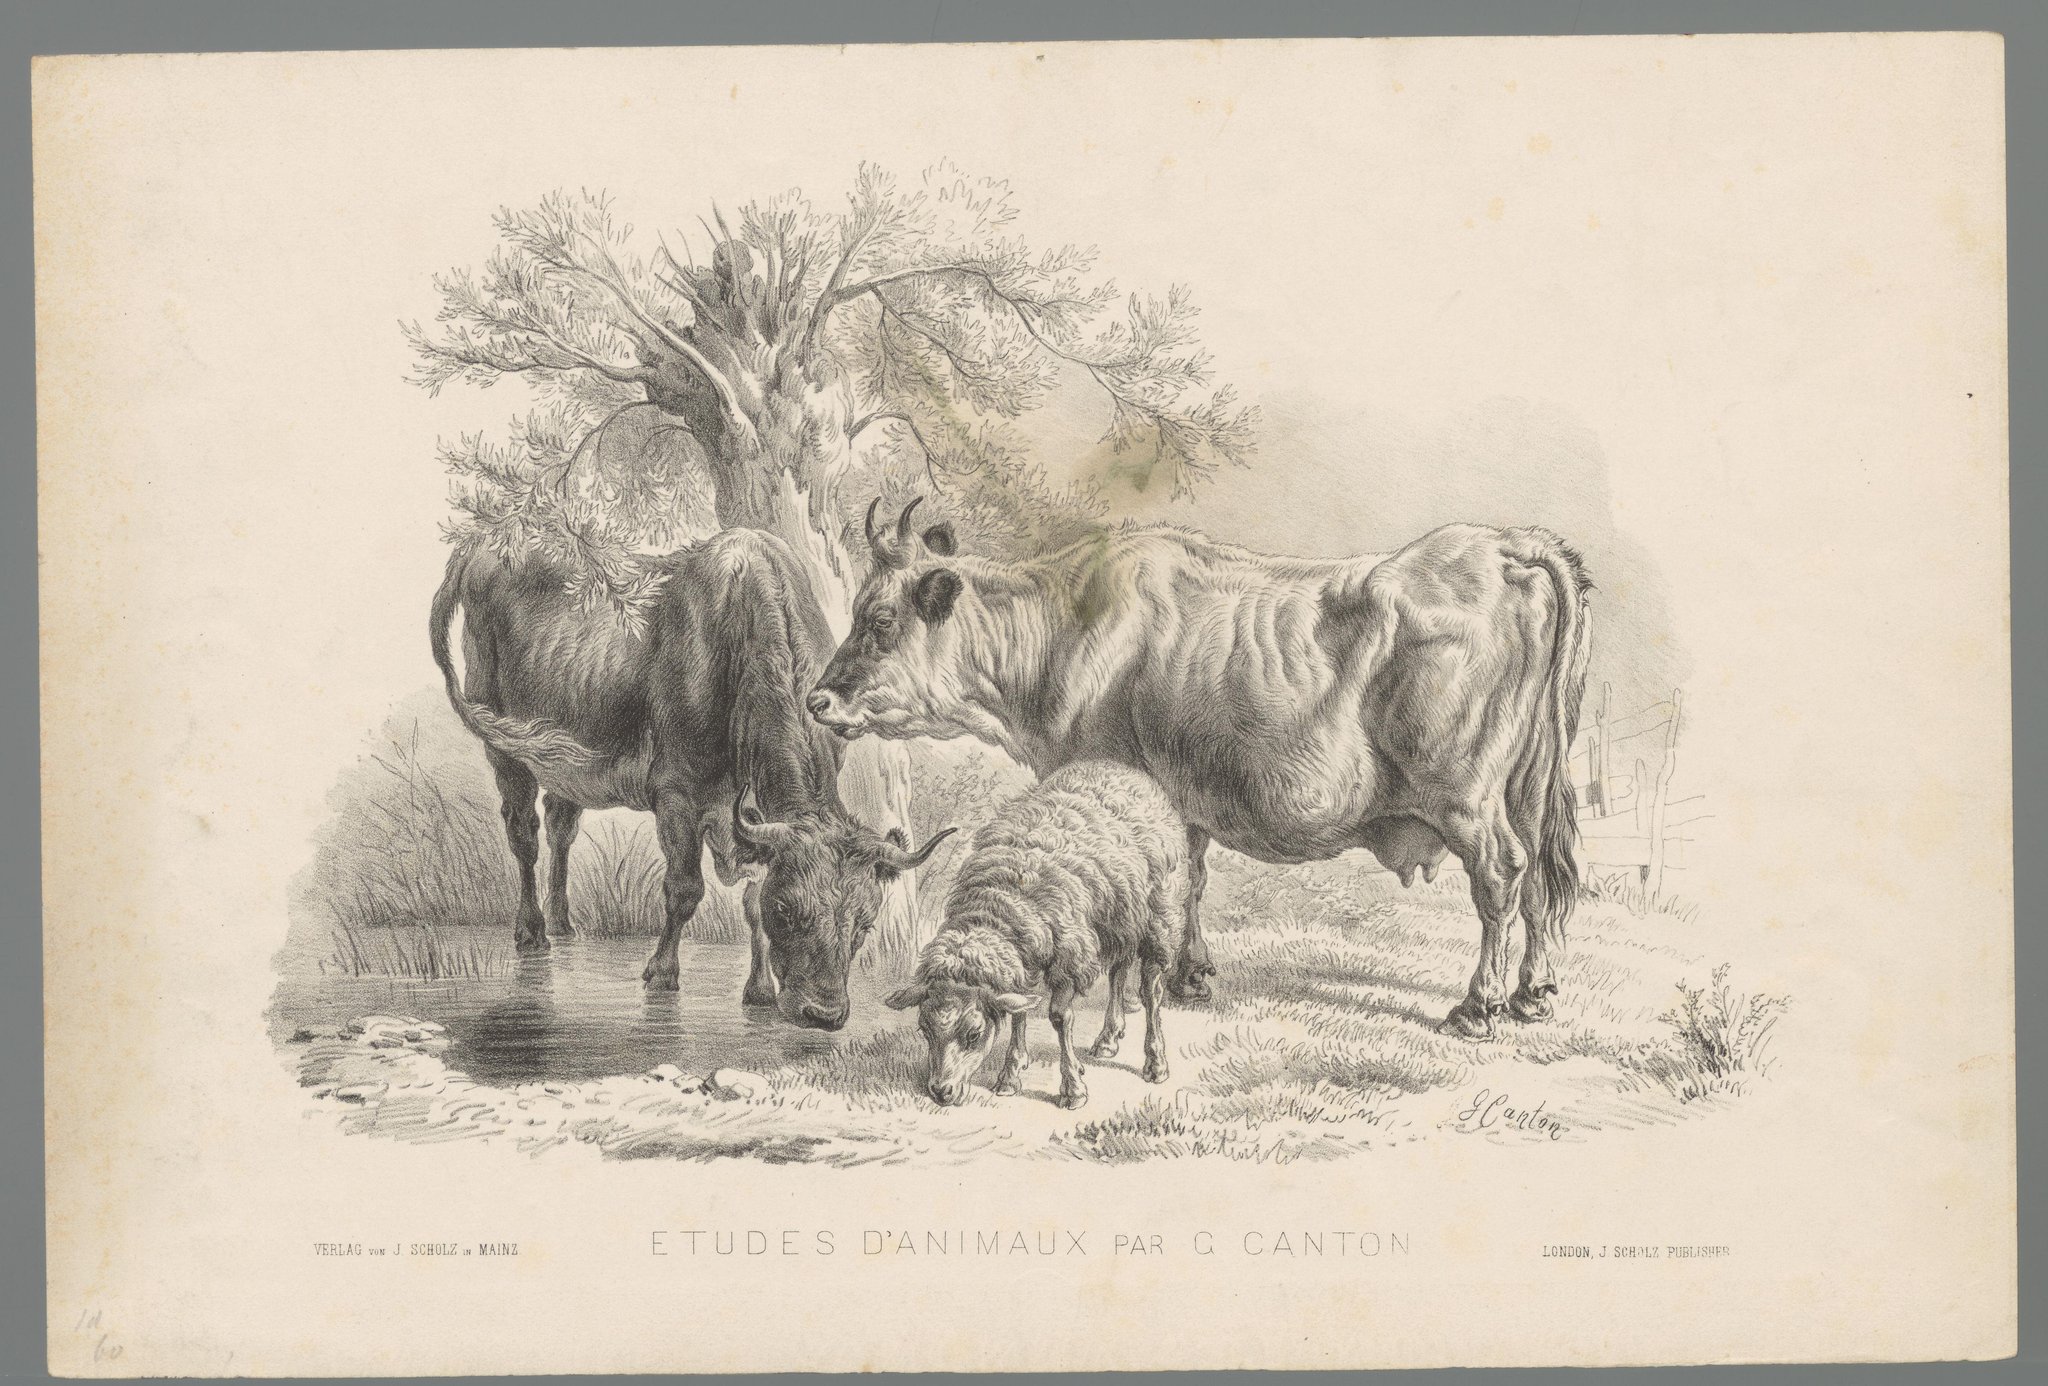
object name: print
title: Dierstudies door Gustav Canton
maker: gustav jakob canton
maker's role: print maker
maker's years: 1813-1885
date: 1823-1885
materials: paper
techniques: lithograph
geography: mainz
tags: landscapes with waters, waterscapes, seascapes (in the temperate zone), sheep, bovine cattle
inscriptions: collector's mark: Lugt 2228